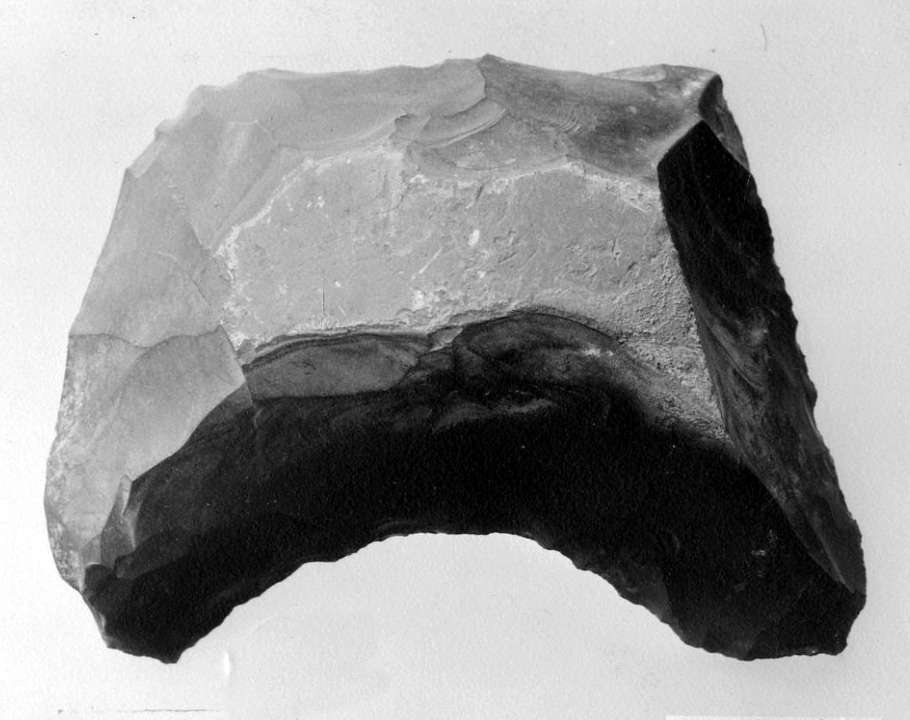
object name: tool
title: Tool (?)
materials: stone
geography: egypt